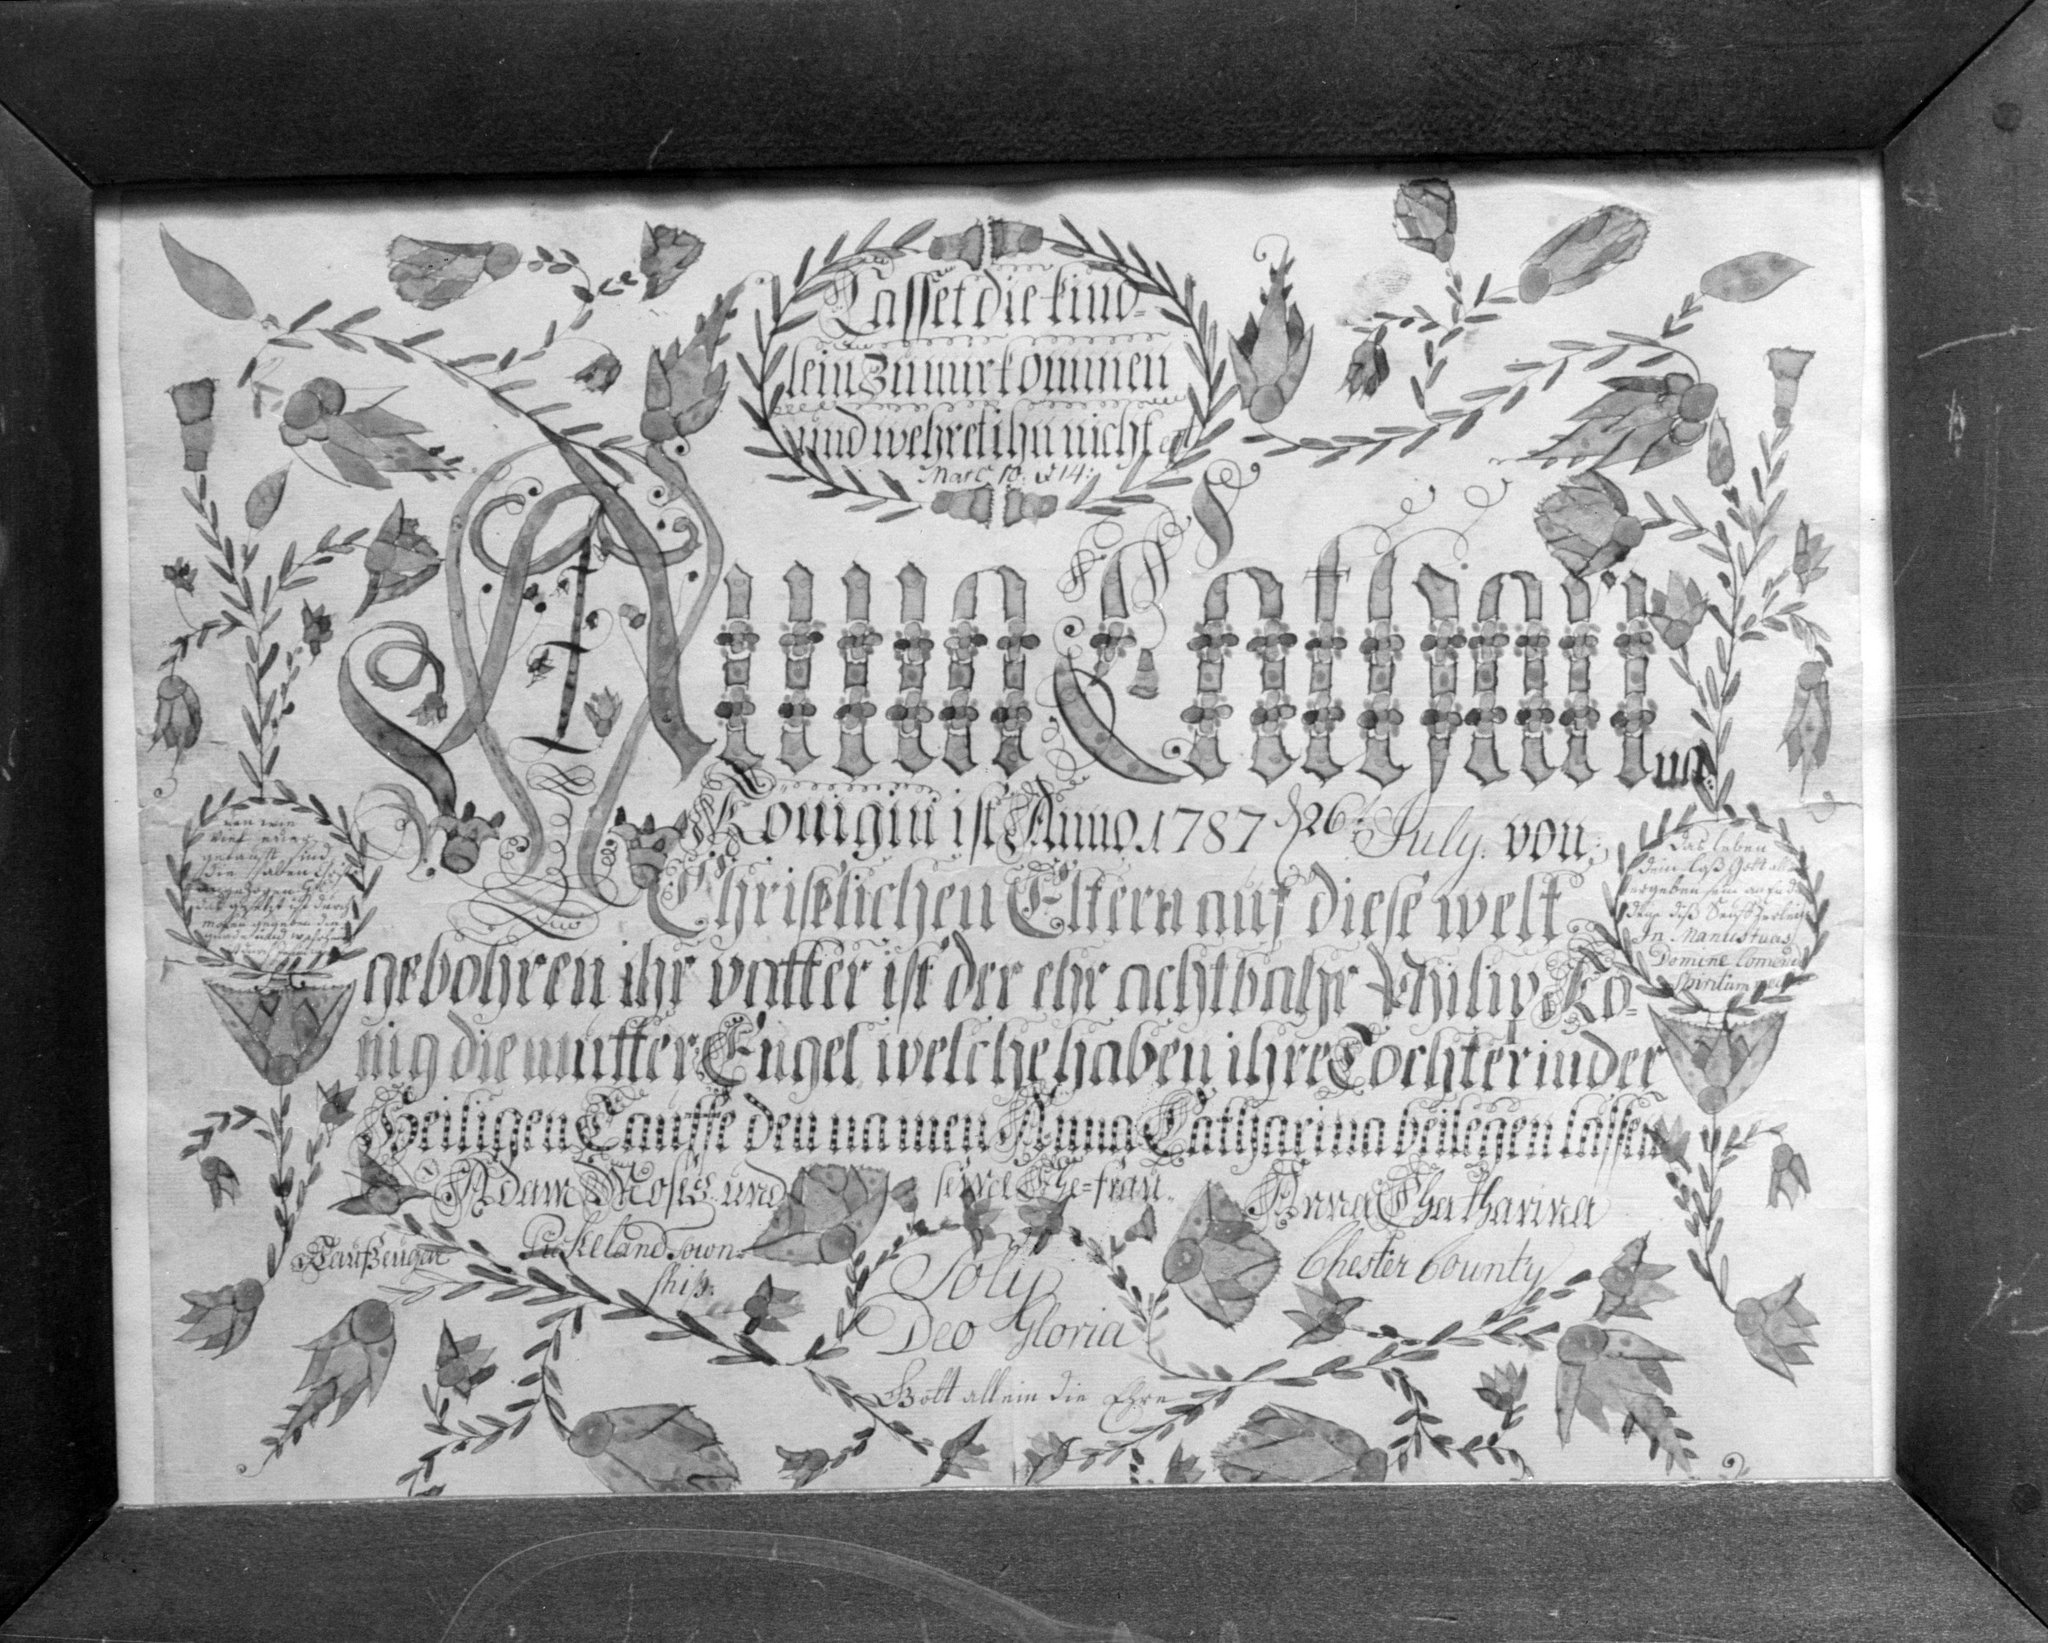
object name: birth and baptismal certificate, fraktur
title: Birth and Baptismal Certificate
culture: american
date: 1787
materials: ink, paper, watercolor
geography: united states